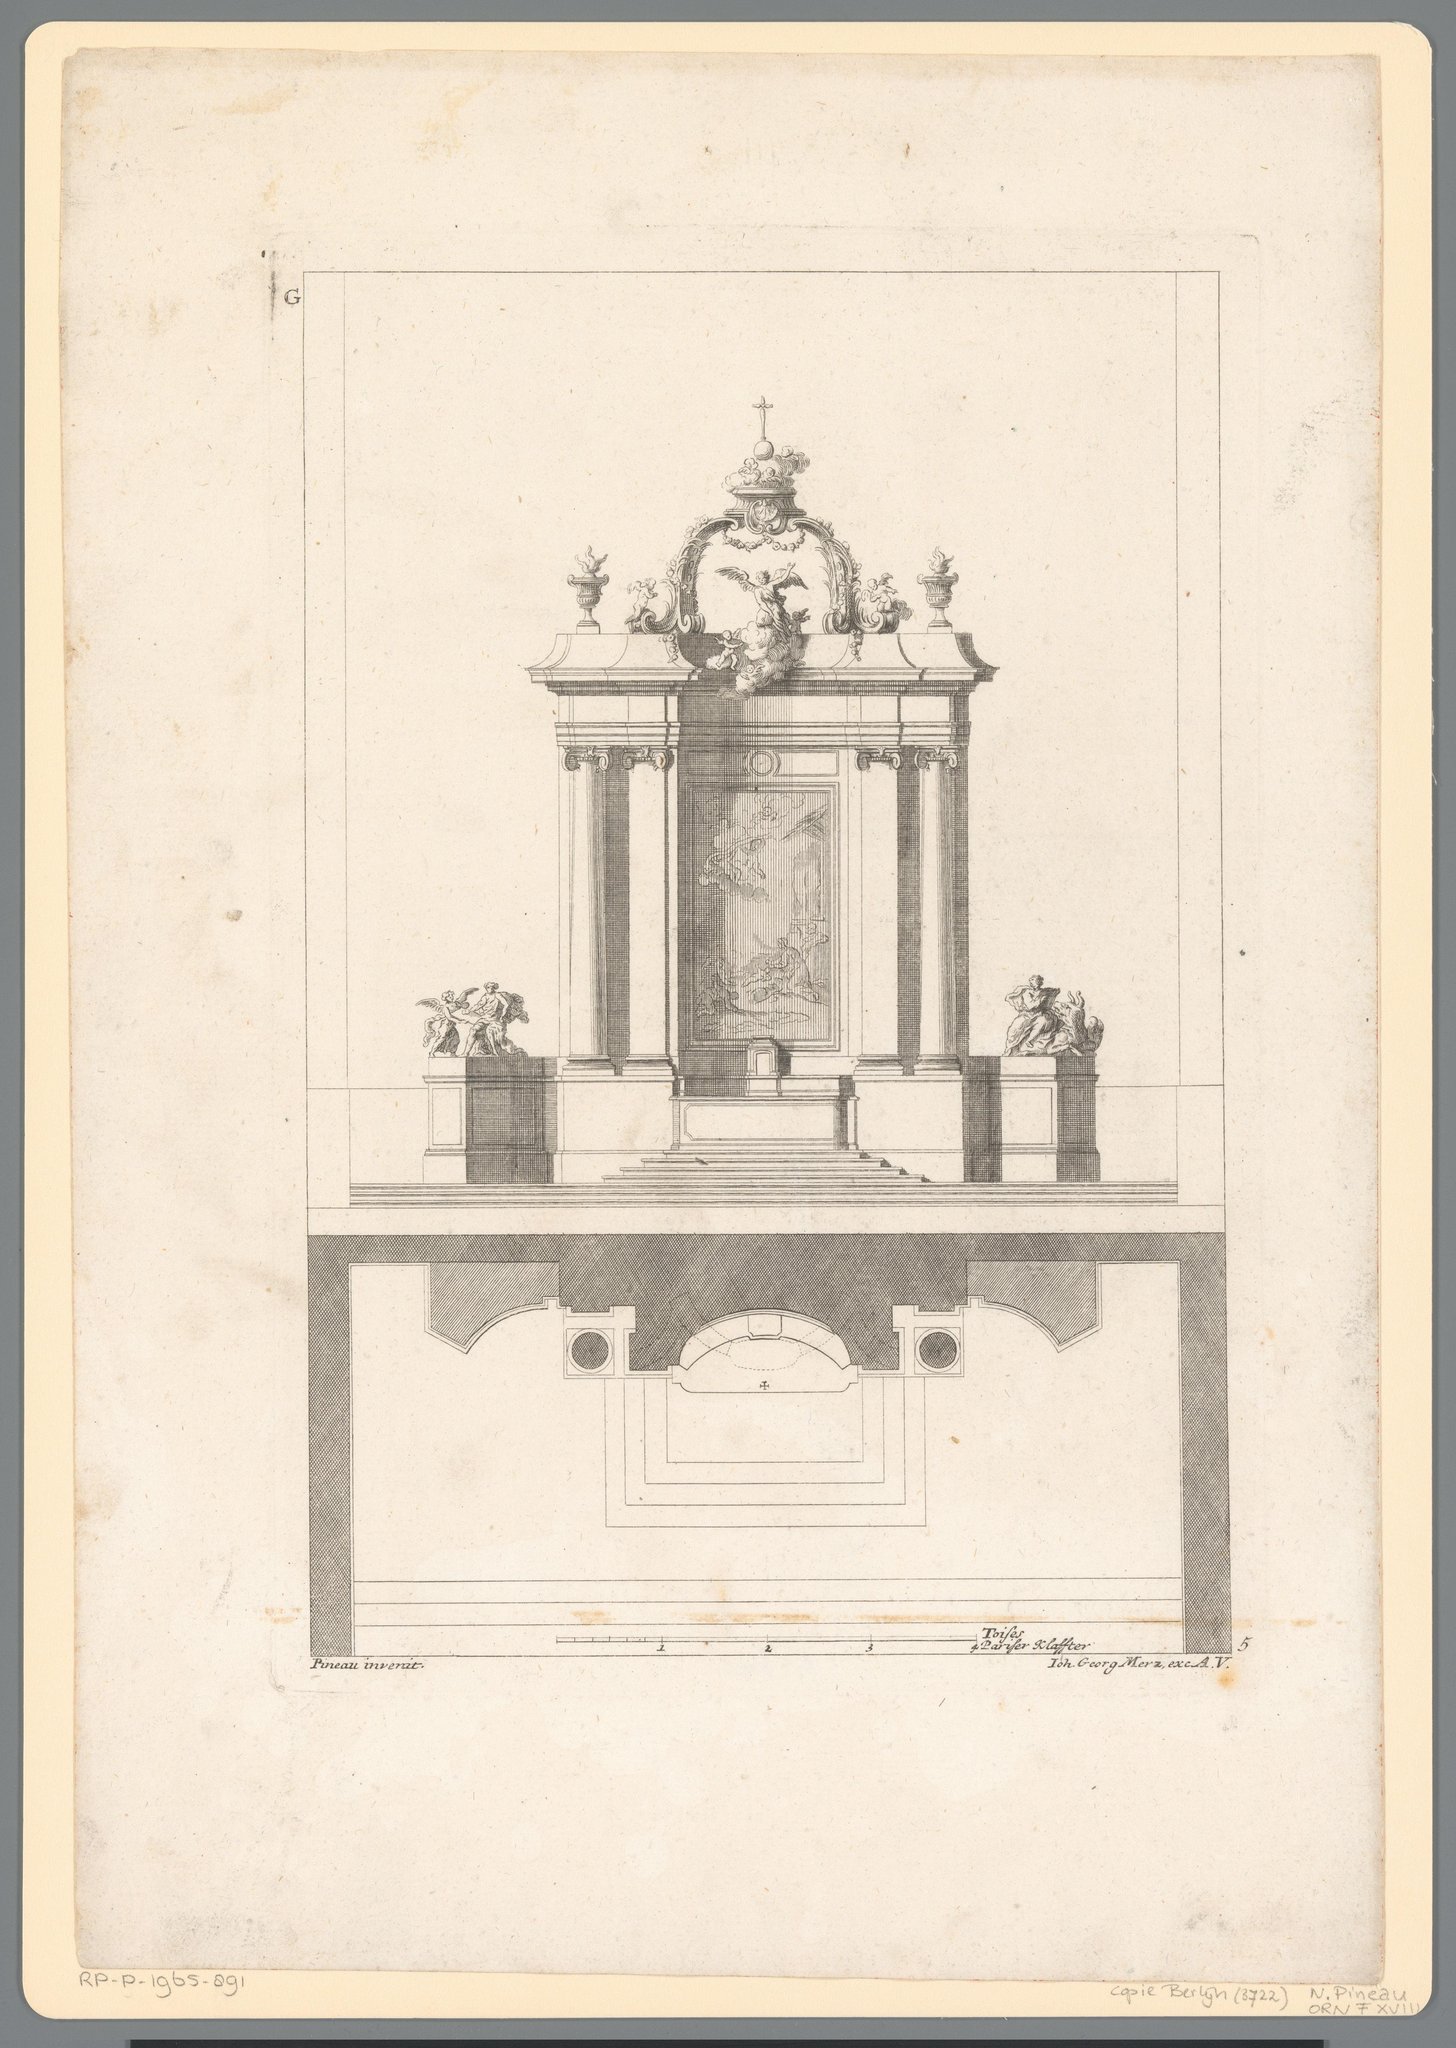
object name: ornament print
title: Altaar met evangelisten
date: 1704-1762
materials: paper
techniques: engraving, etching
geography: augsburg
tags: luke the evangelist; possible attributes: book, (winged) ox, portrait of the virgin, surgical instruments, painter's utensils, scroll, the apostle and evangelist matthew (mattheus); possible attributes: angel, axe, book, halberd, pen and inkhorn, purse, scroll, square, sword, altar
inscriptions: collector's mark: Lugt 2228, collector's mark: Lugt 2760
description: Vooraanzicht en plattegrond van een altaar met pilasters en een paneel met schildering. Daarboven vazen, engelen, putti en een kruis. Links en rechts de evangelisten Matteüs en Lucas.